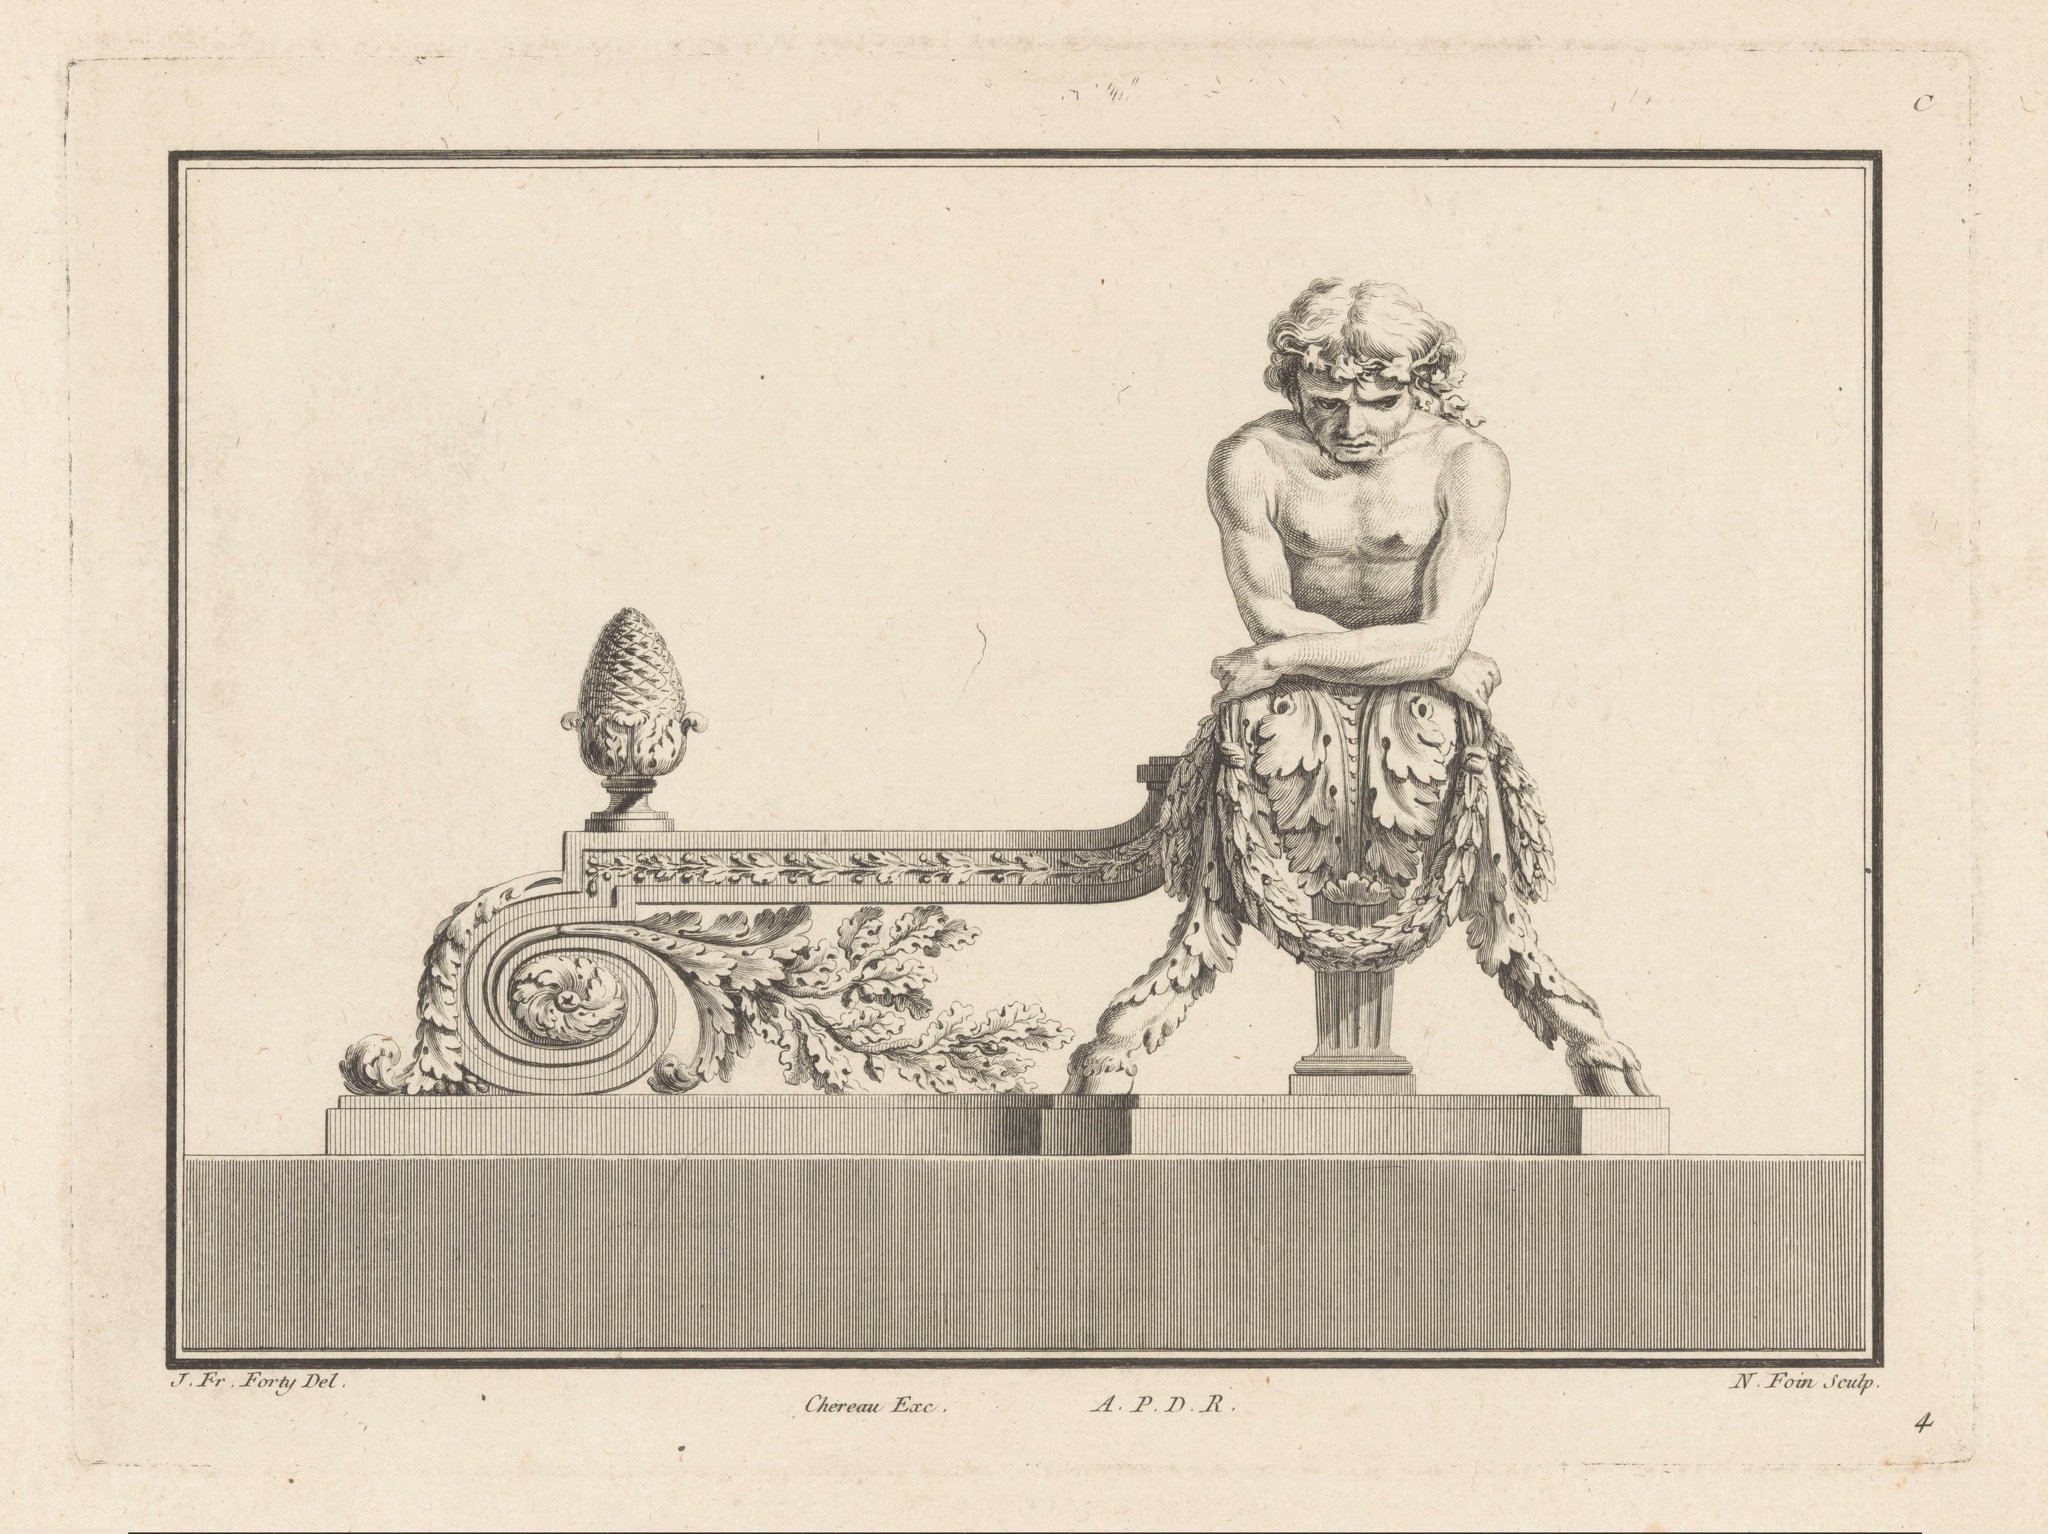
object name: ornament print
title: Vuurbok met man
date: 1775-1790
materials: paper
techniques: engraving, etching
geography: paris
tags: leaning forward, andiron, fire-dog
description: Een geornamenteerde vuurbok met rechts een man leunend op ranken en bokkenpoten. Links een dennenappel.